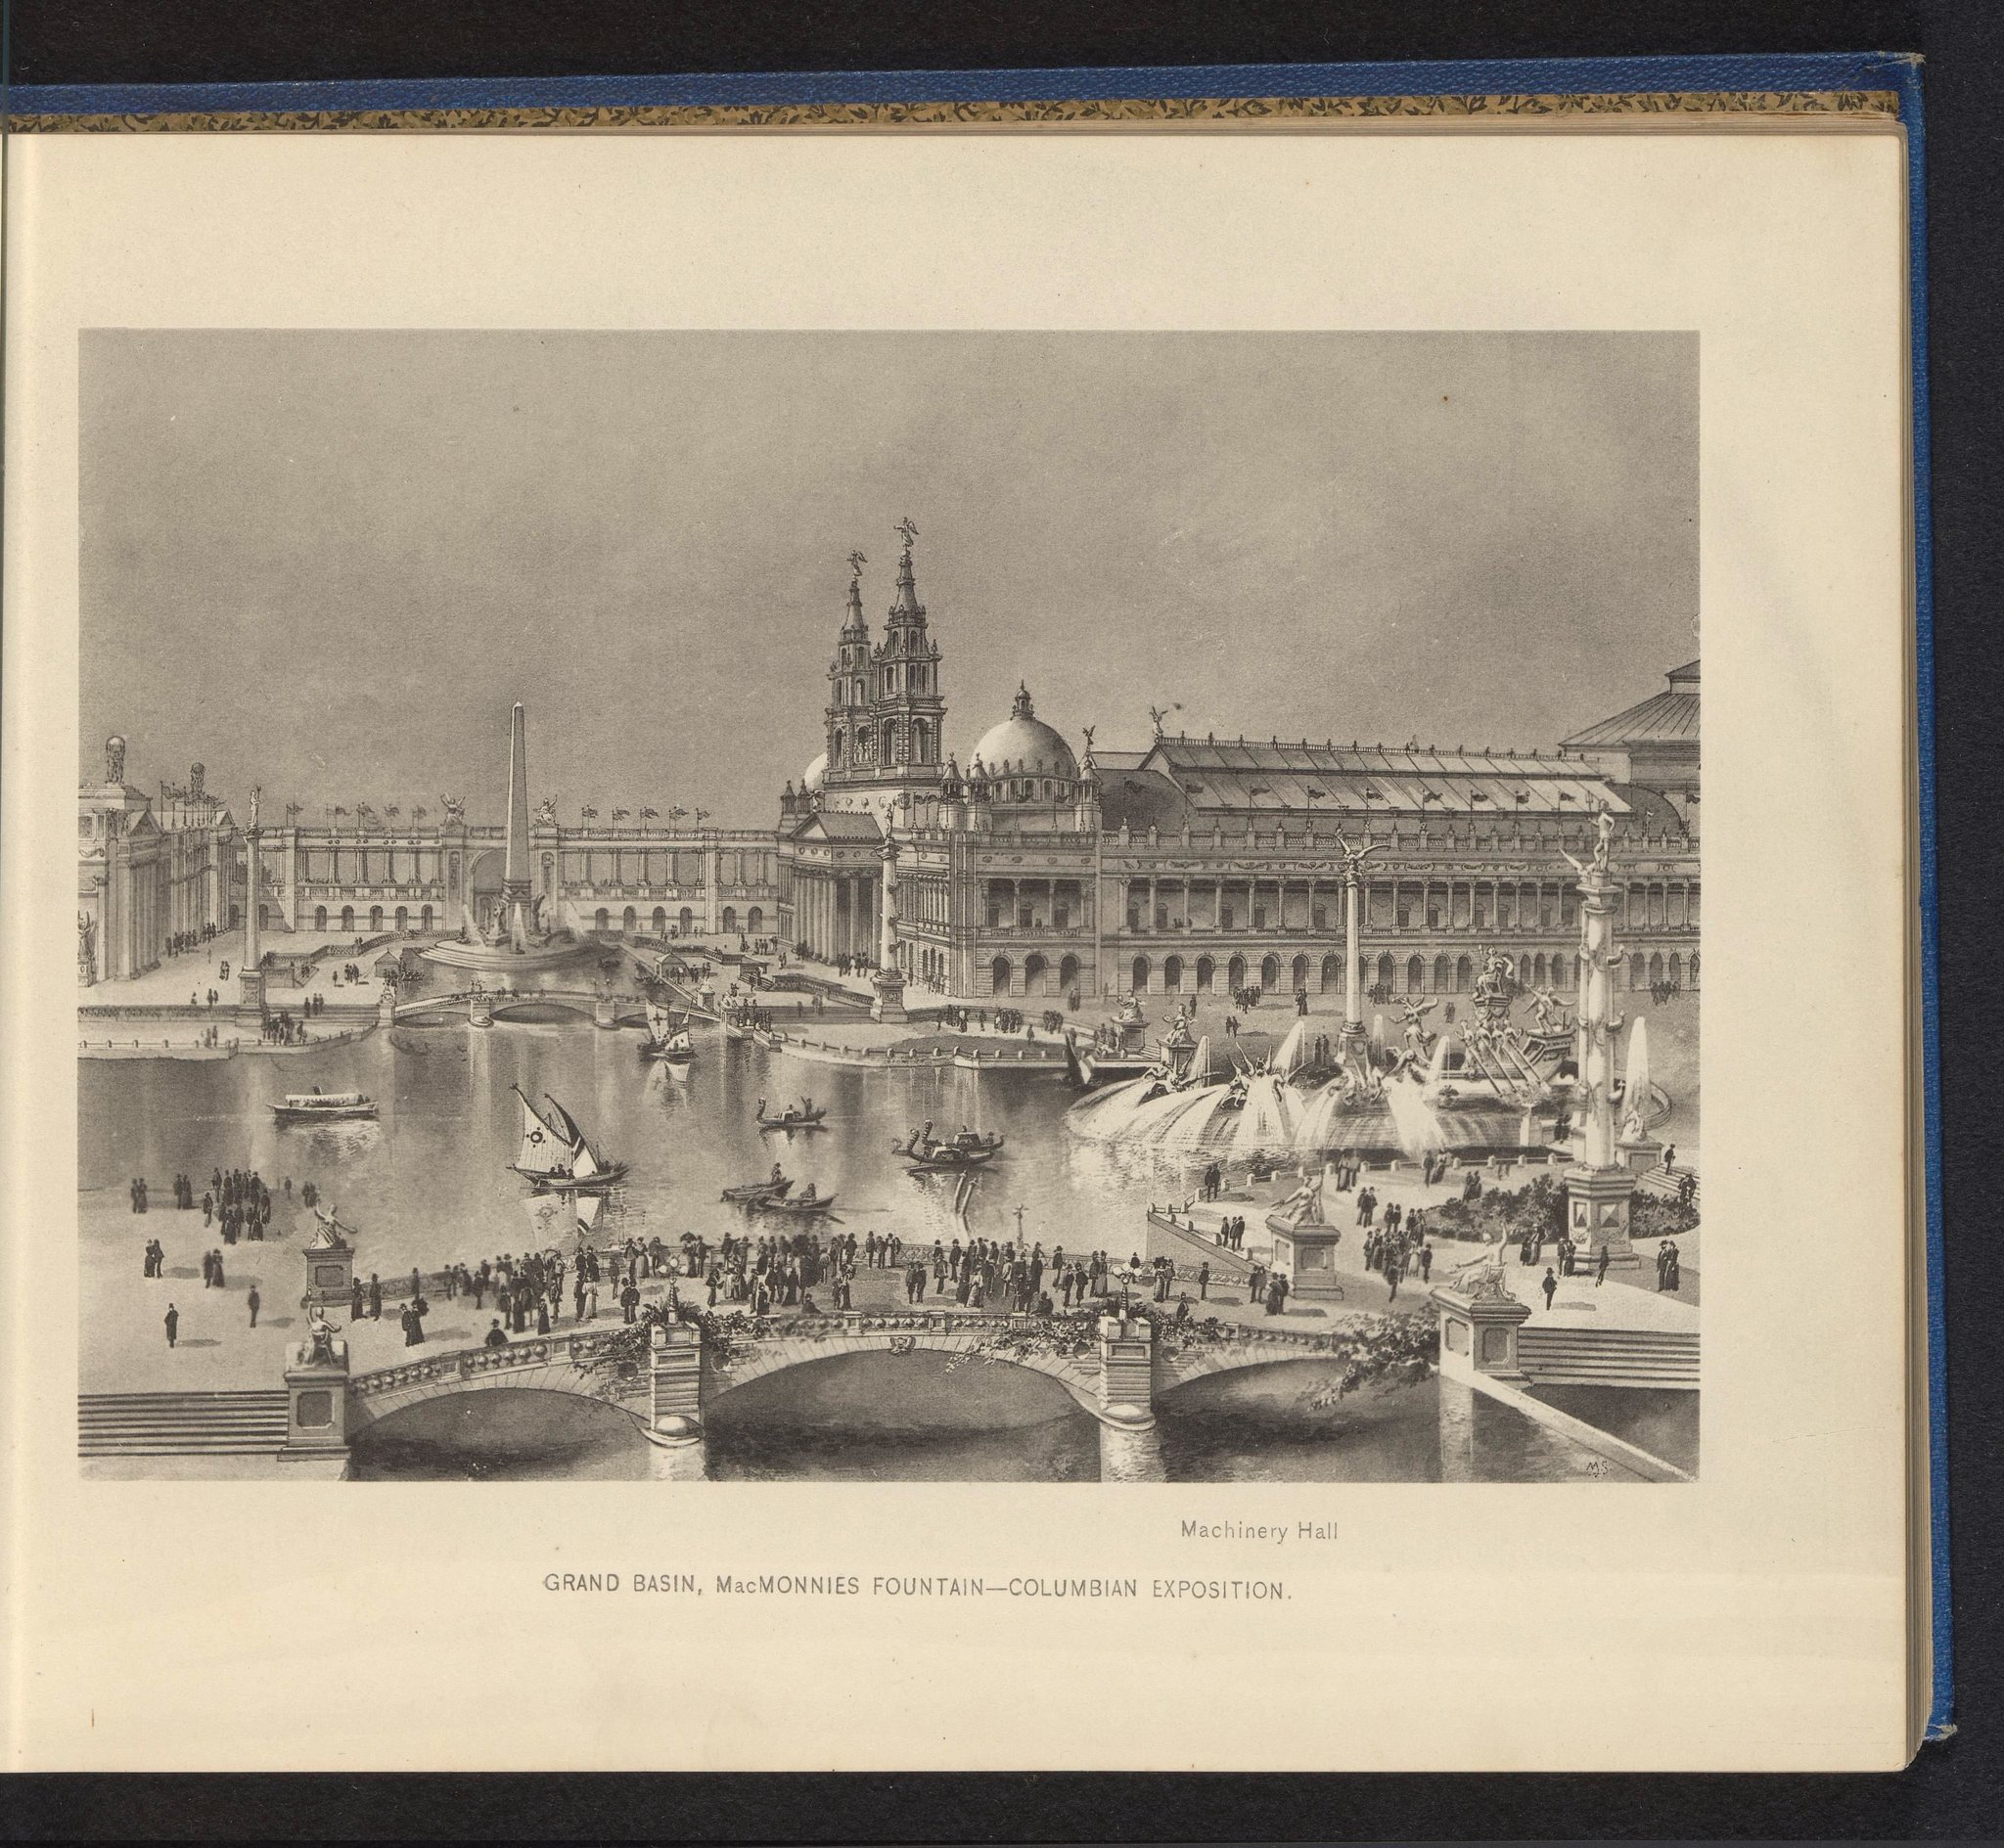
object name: photomechanical print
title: Grand Basin, MacMonnies Fountain - Columbian Expostition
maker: Anonymous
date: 1893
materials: paper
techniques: photograph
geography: united states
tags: world fair, world exhibition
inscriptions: inscription: ‘Machinery Hall’